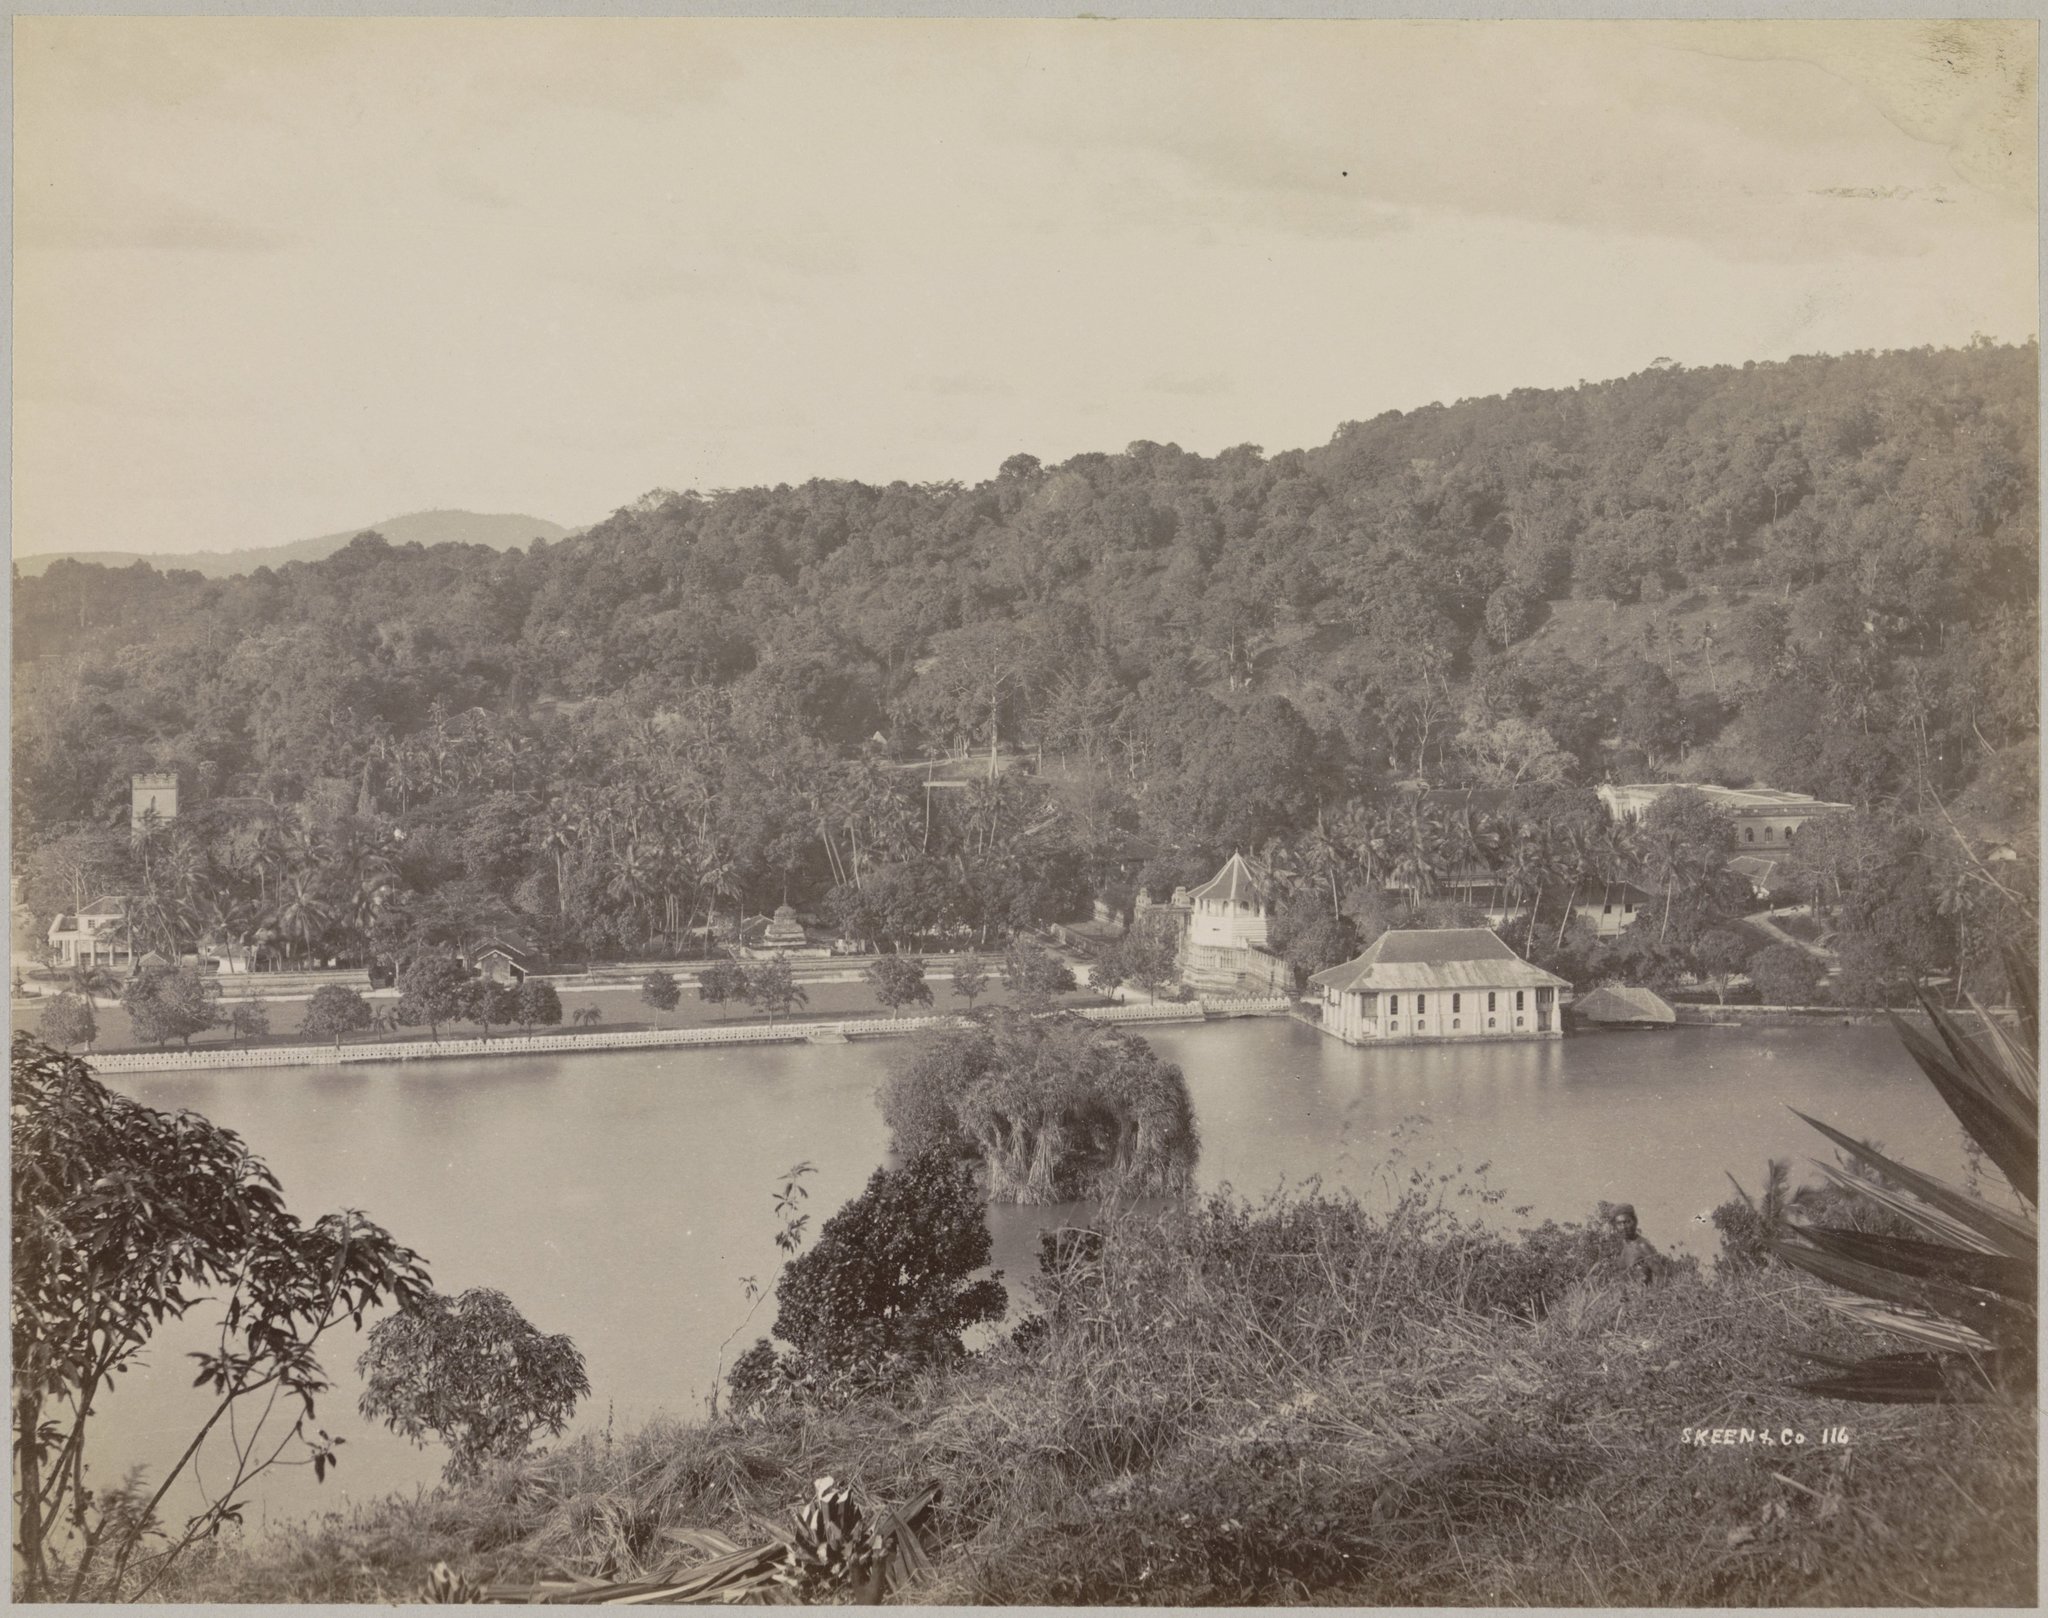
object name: photograph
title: View of the Temple of the Tooth (Dalada Maligawa), Kandy, Sri Lanka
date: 1903-1914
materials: cardboard, paper, photographic support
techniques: albumen print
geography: kandy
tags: kandy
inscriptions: name: ‘Skeen & Co.’, inscription: ‘3. Kandy.’, number: ‘116’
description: Rechts is de Tempel van de Tand (Dalada Maligawa) te zien.